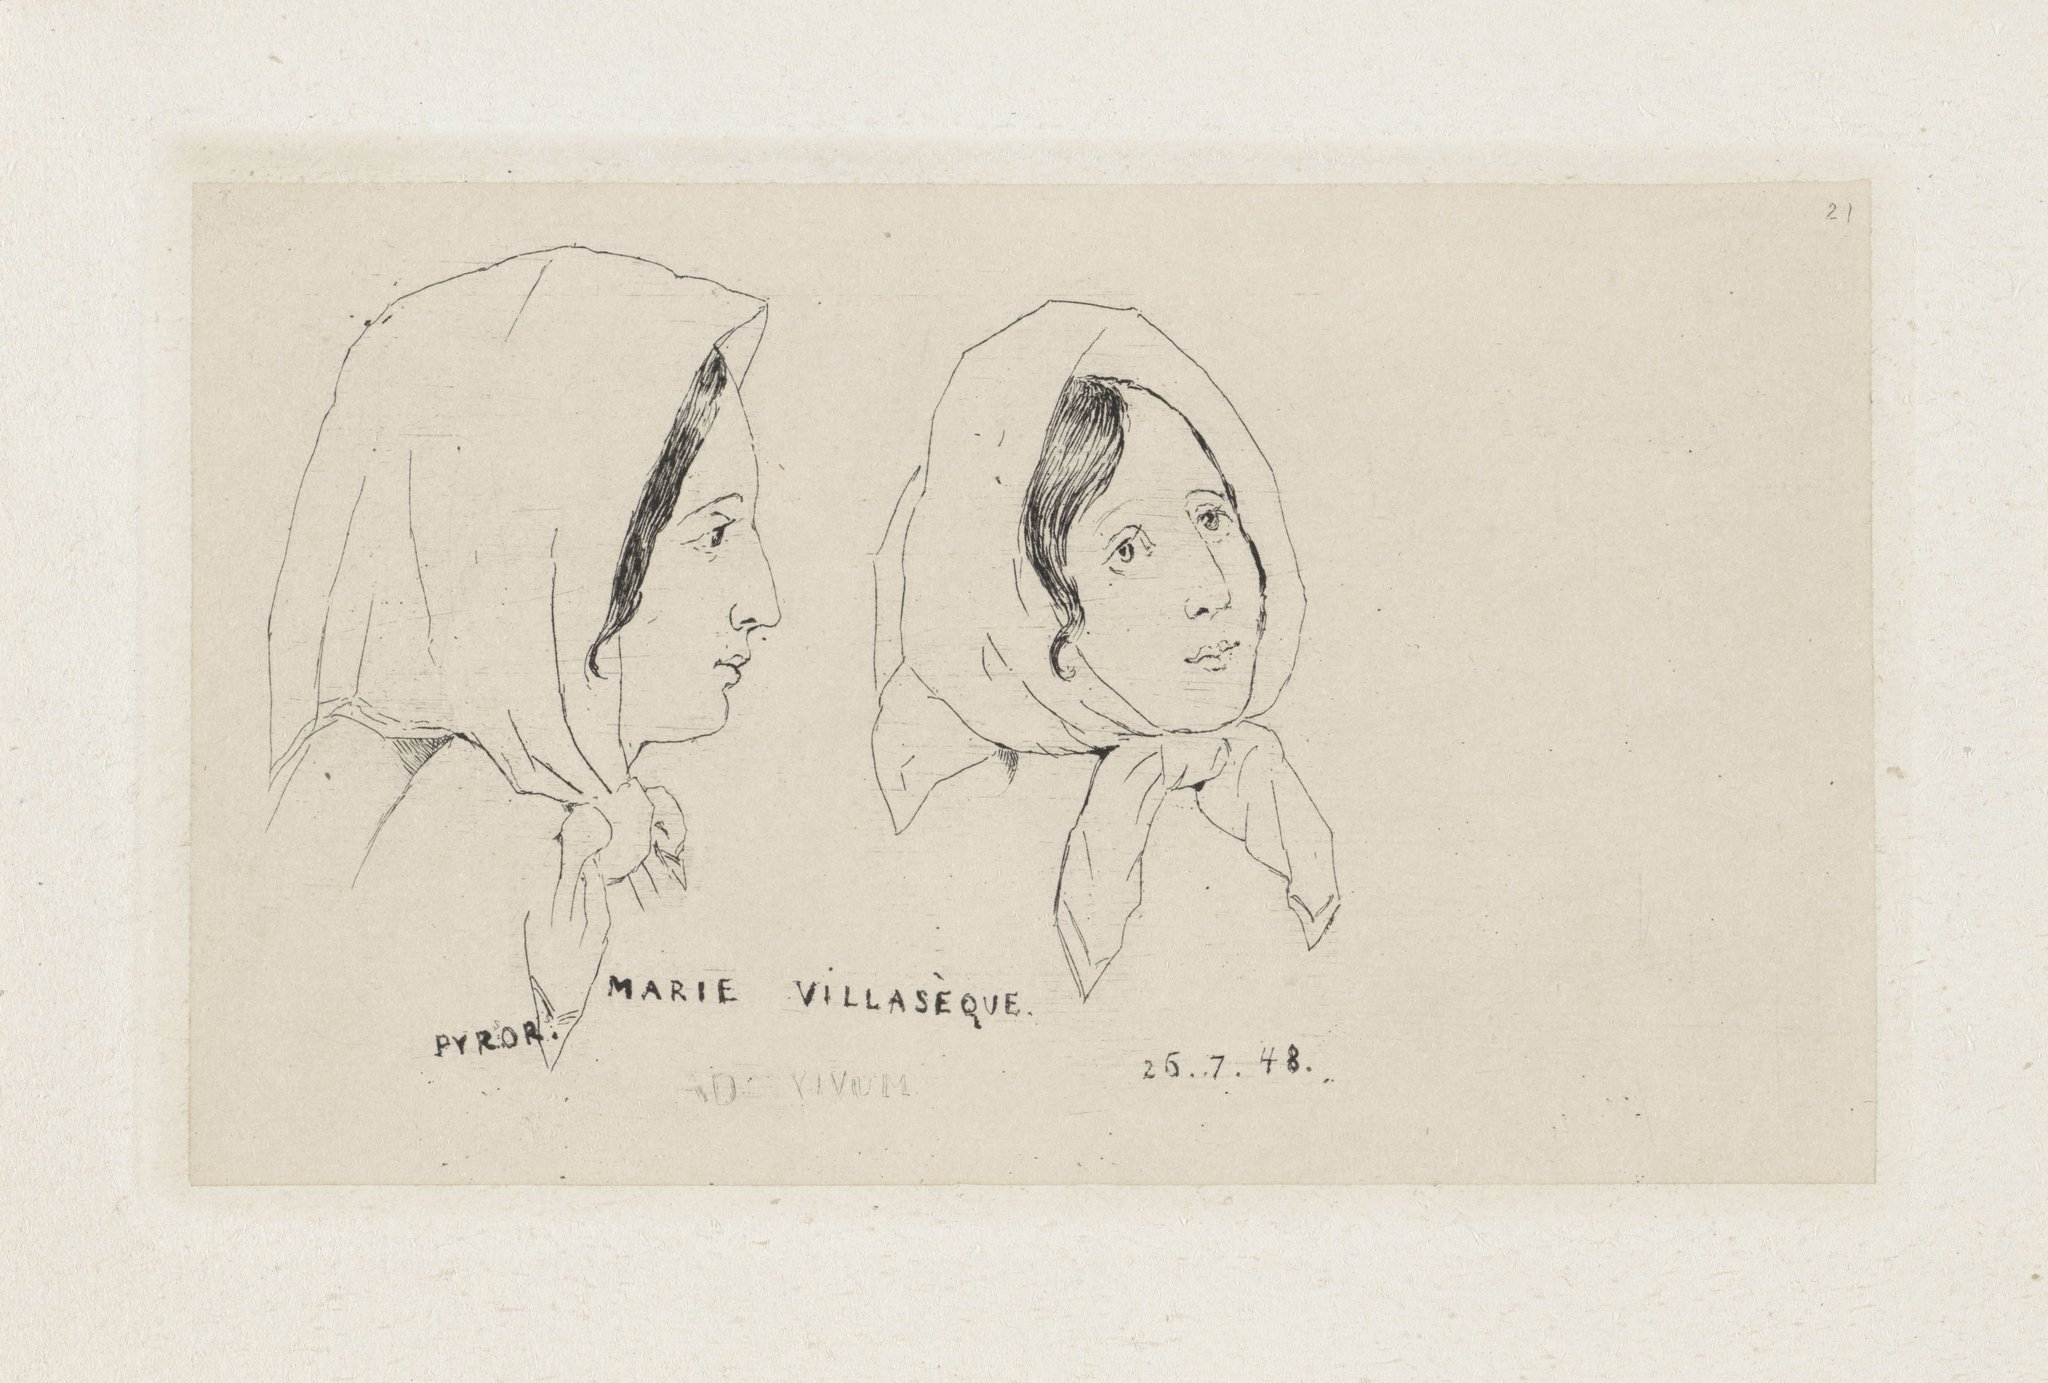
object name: print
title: Marie Villasèque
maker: louis charles hora siccama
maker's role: draughtsman, print maker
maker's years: 1807-1880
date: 1848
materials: paper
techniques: etching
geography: utrecht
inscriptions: collector's mark: Lugt 2228